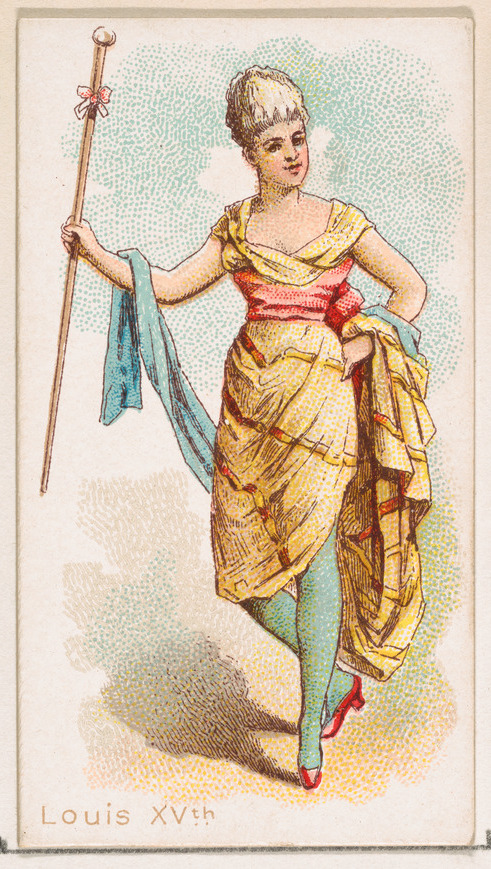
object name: print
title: Louis XVth Dancer, from the Dancing Women series (N186) issued by Wm. S. Kimball & Co.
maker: william s. kimball & company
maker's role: publisher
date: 1889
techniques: color lithograph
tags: women,dancers